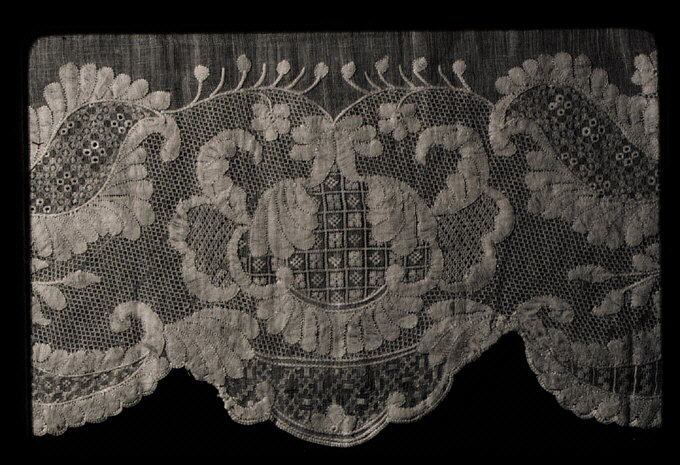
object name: fragment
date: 1601-1700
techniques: lace